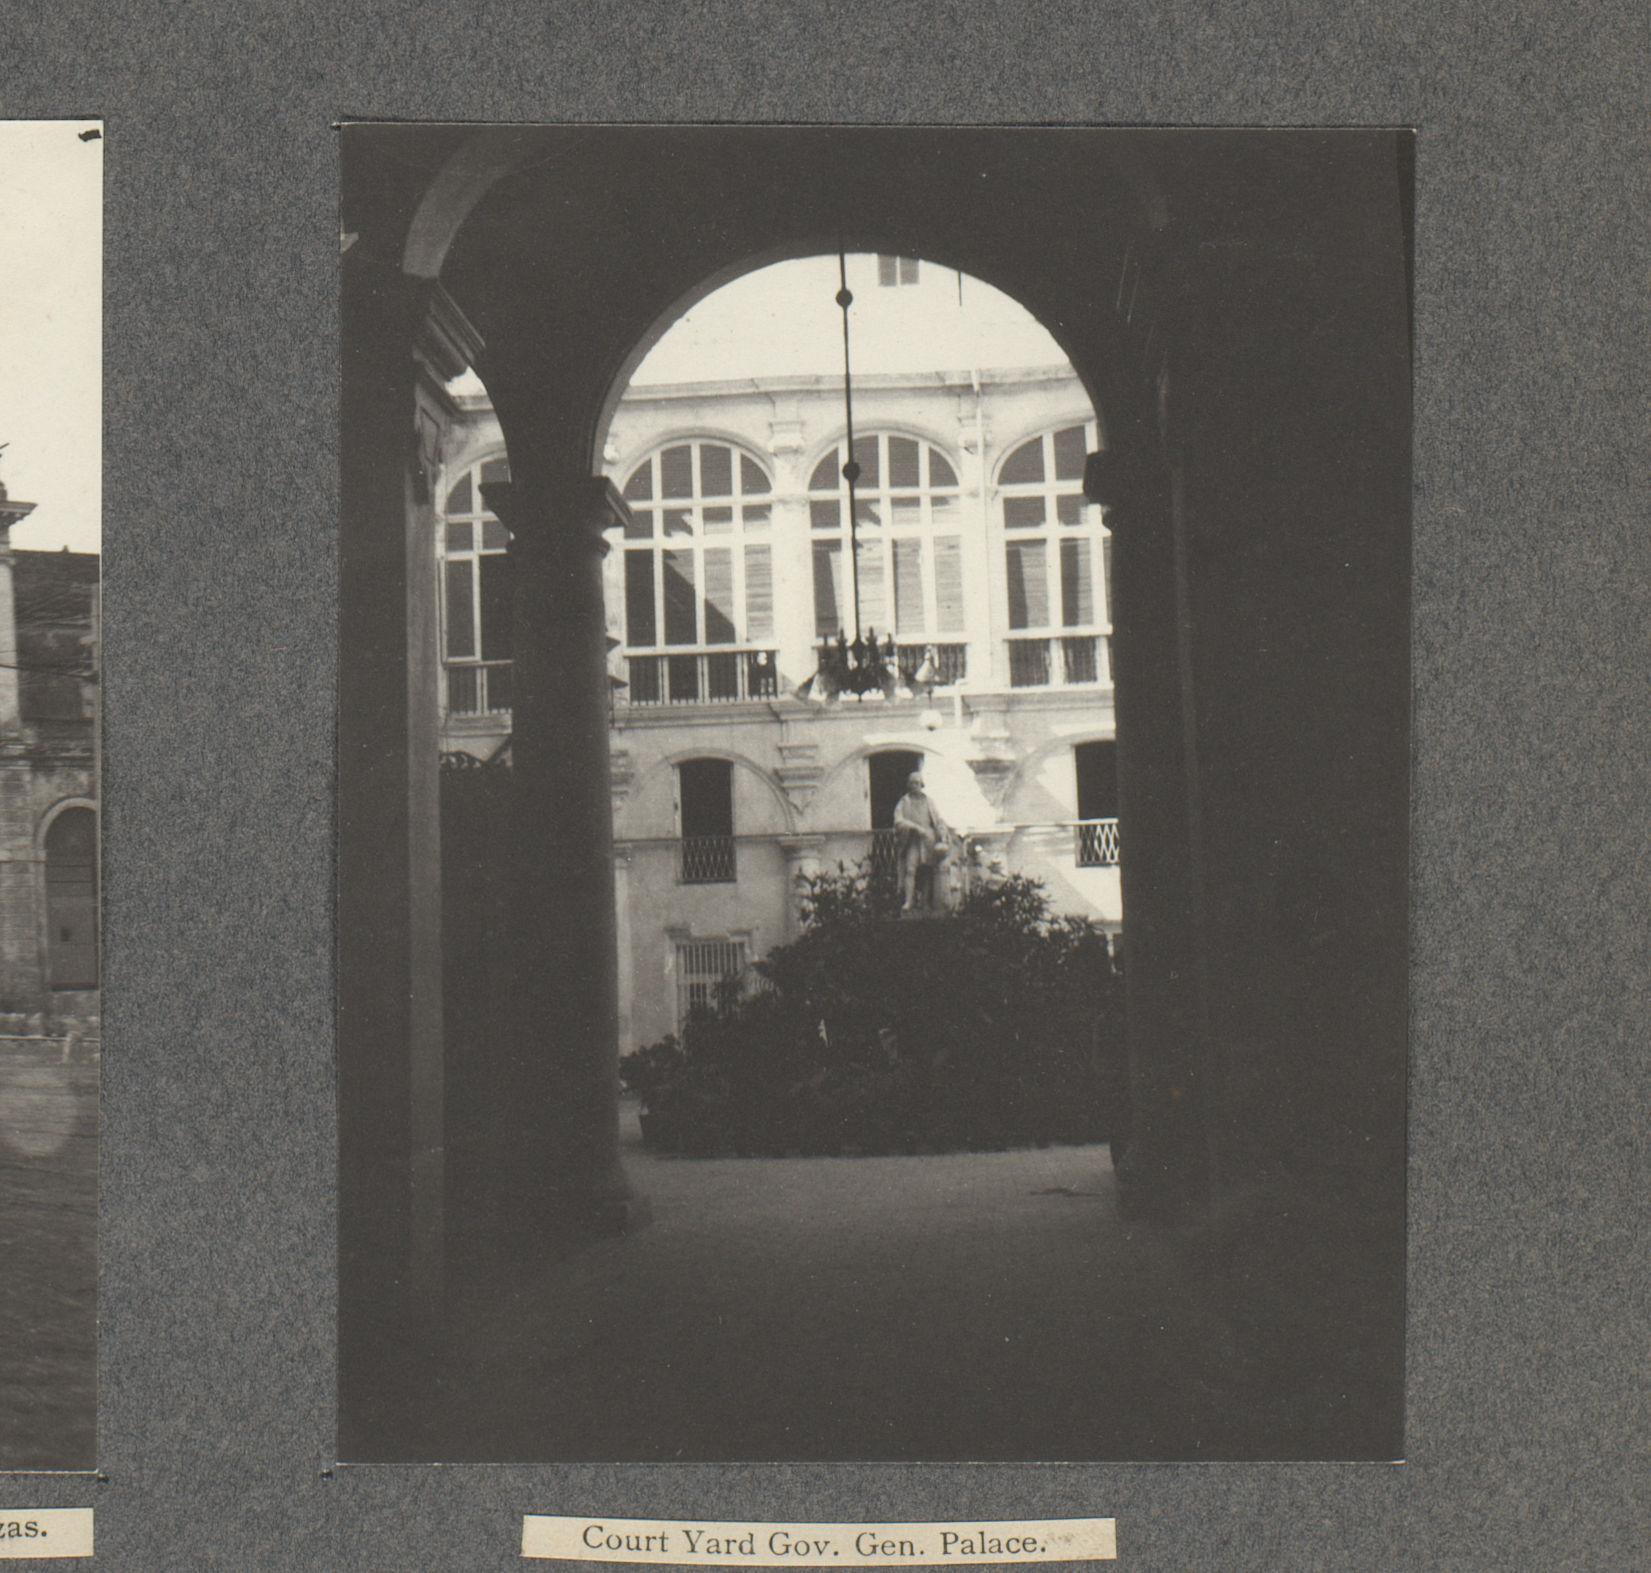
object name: photograph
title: Gezicht op de binnenplaats van het Palacio de los Capitanes Generales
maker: Anonymous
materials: paper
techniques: platinum process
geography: havana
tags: courtyard